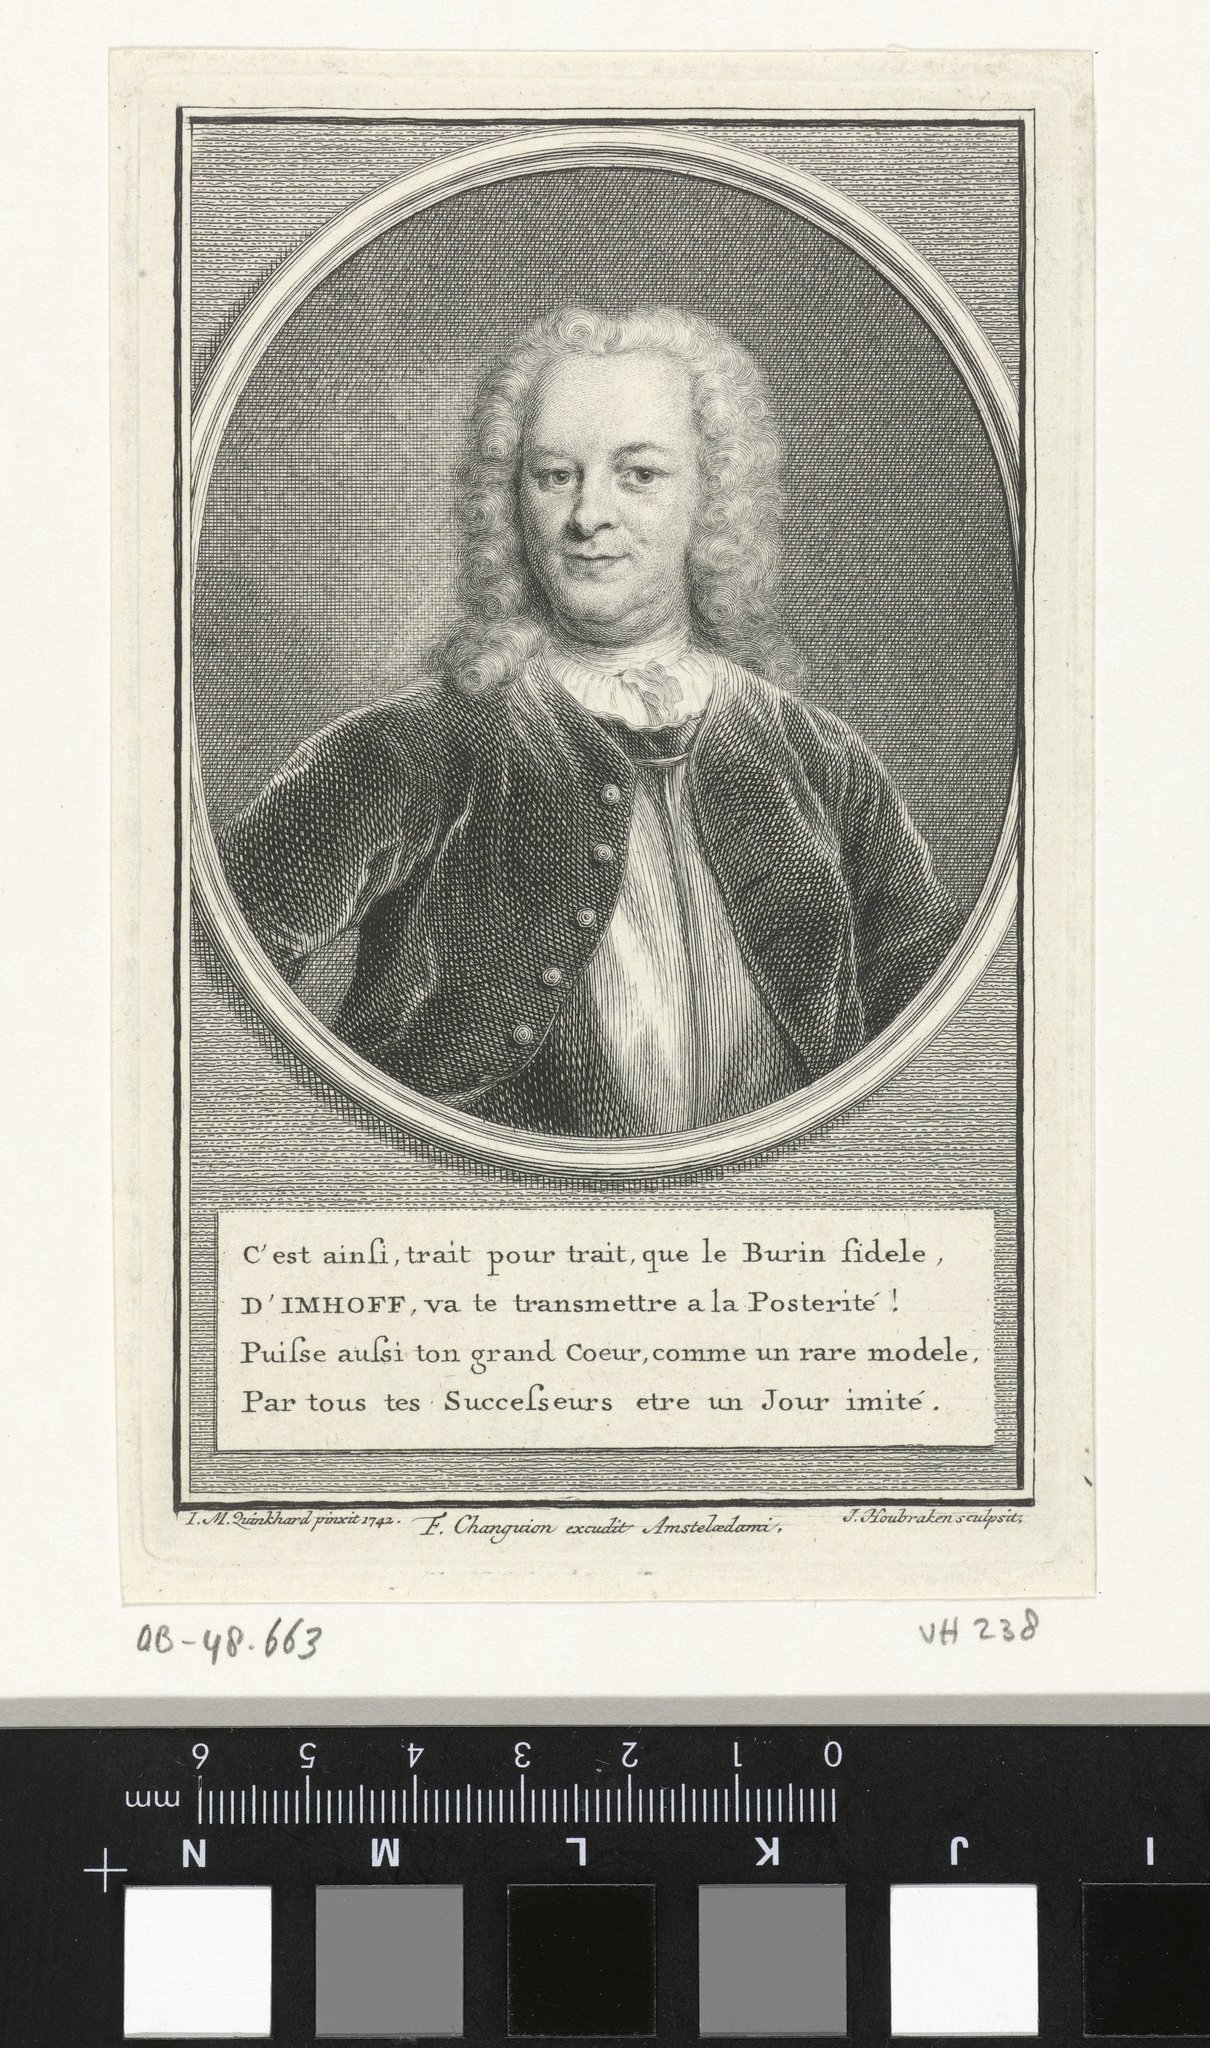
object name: print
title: Portret van Gustaaf Willem Baron van Imhoff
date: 1708-1780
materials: paper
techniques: engraving, etching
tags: gouverneur-generaal, gustaaf willem baron van imhoff (1705-1750)